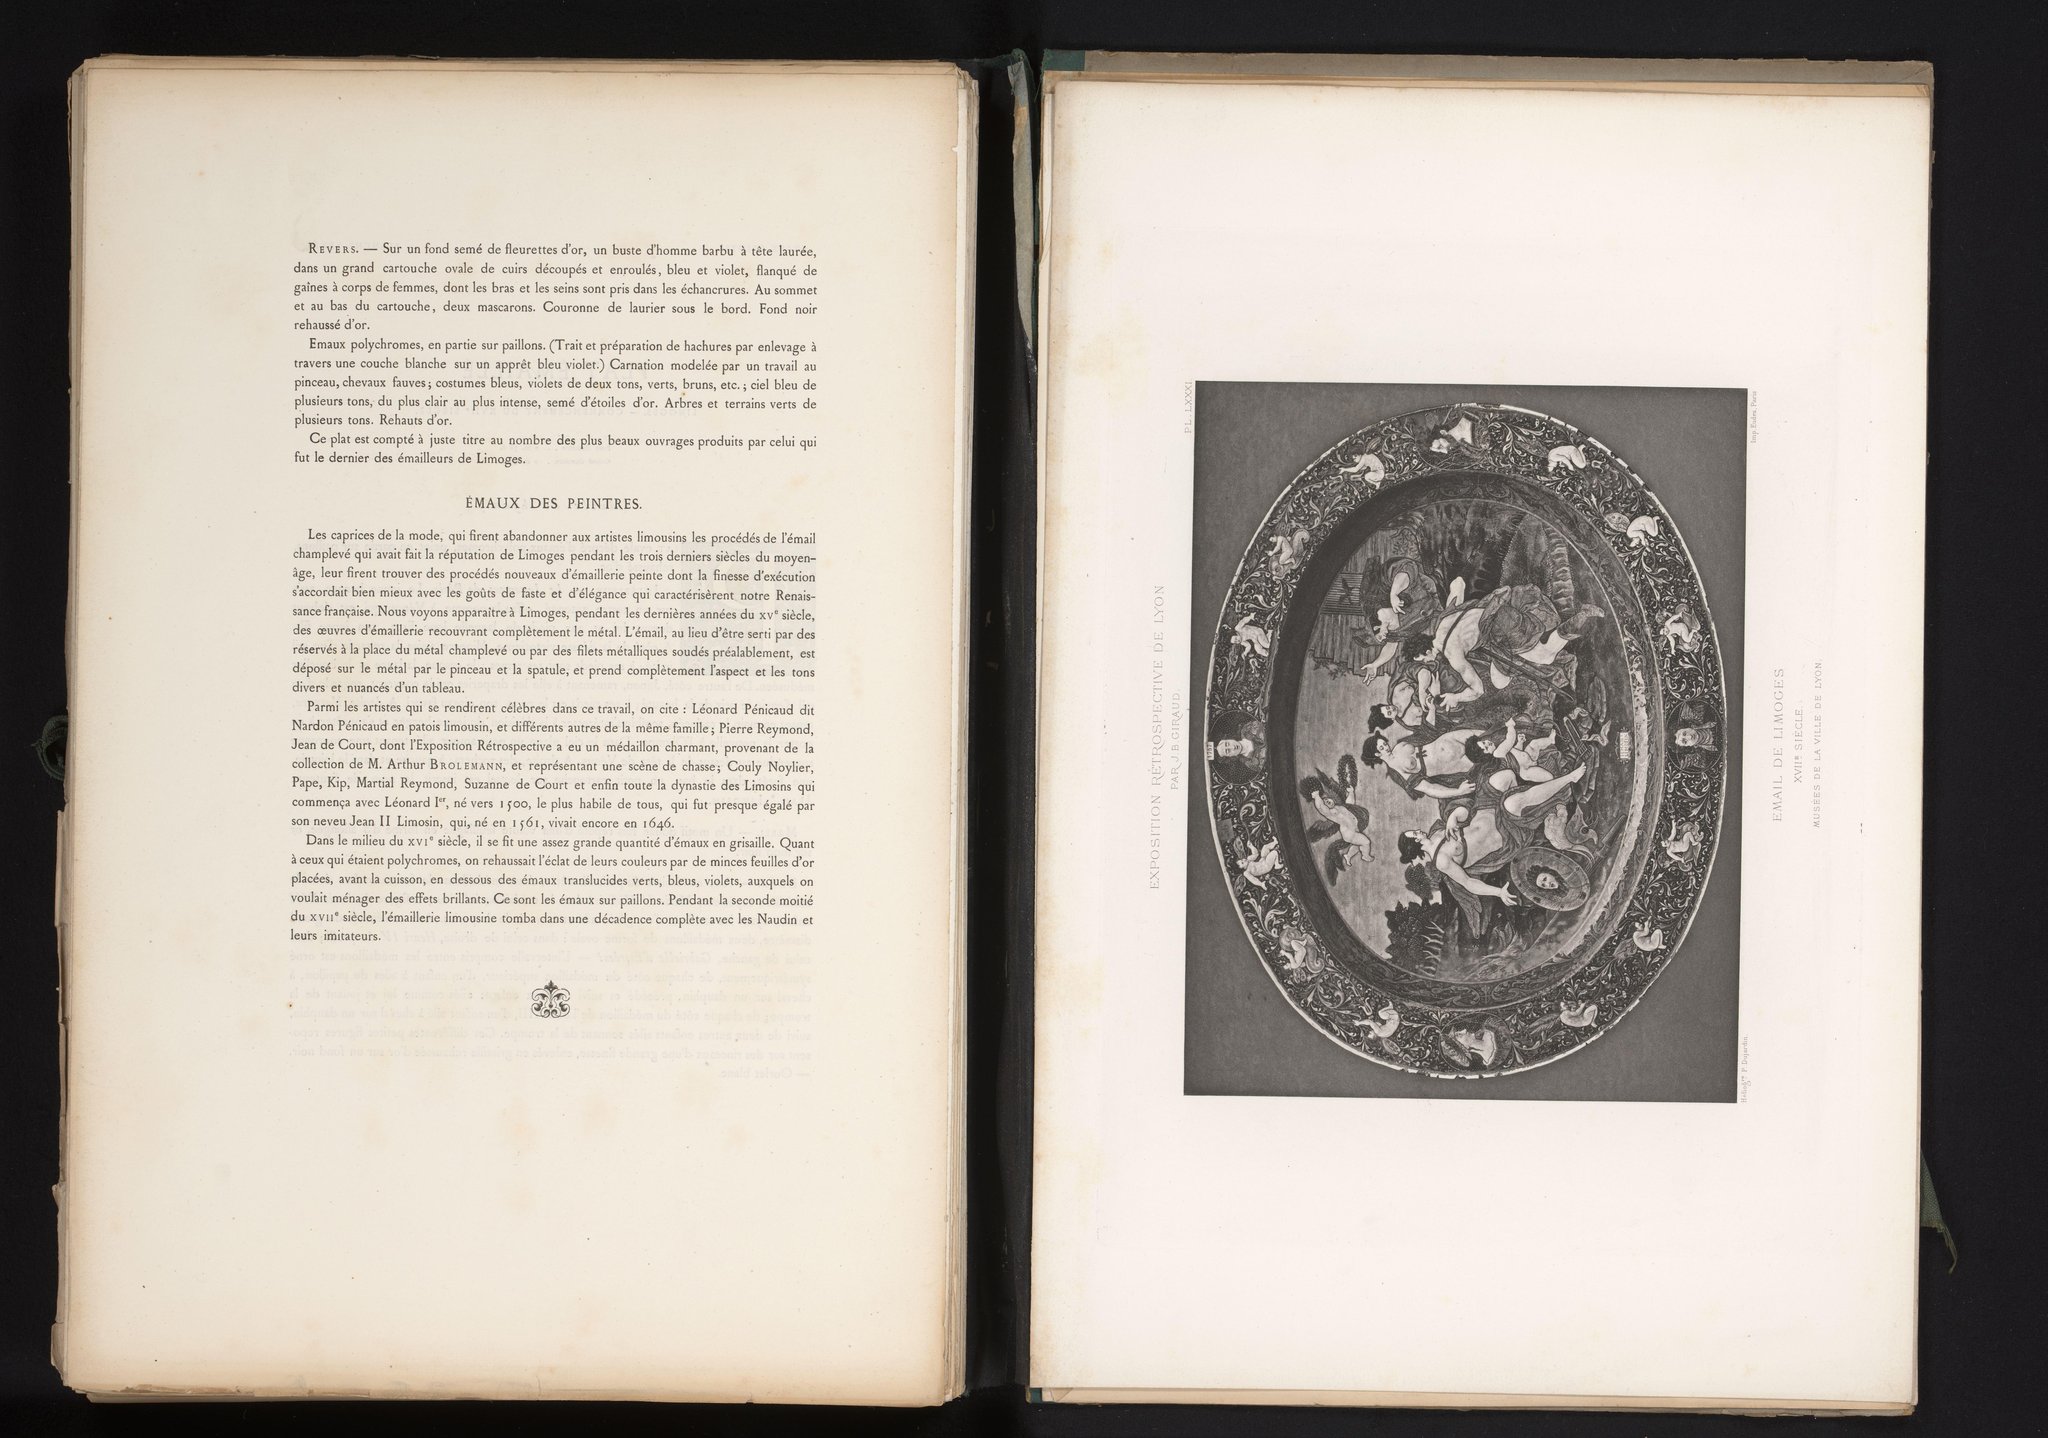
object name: photomechanical print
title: 17de-eeuws emaillen bord, op de Exposition Rétrospective van 1877 in Lyon, Frankrijk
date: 1877-1878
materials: paper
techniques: photoaquatint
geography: lyon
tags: dish, plate, saucer, lyon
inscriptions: inscription: ‘EMAIL DE LIMOGES/ XVIIe SIÈCLE/ MUSÉES DE LA VILLE DE LYON.’, number: ‘PL. LXXXI.’, inscription: ‘EXPOSITION RÉTROSPECTIVE DE LYON/ PAR J. B. GIRAUD.’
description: Deze prent maakt deel uit van een omslag met 79 prenten op 54 bladen en 65 tekstbladen.